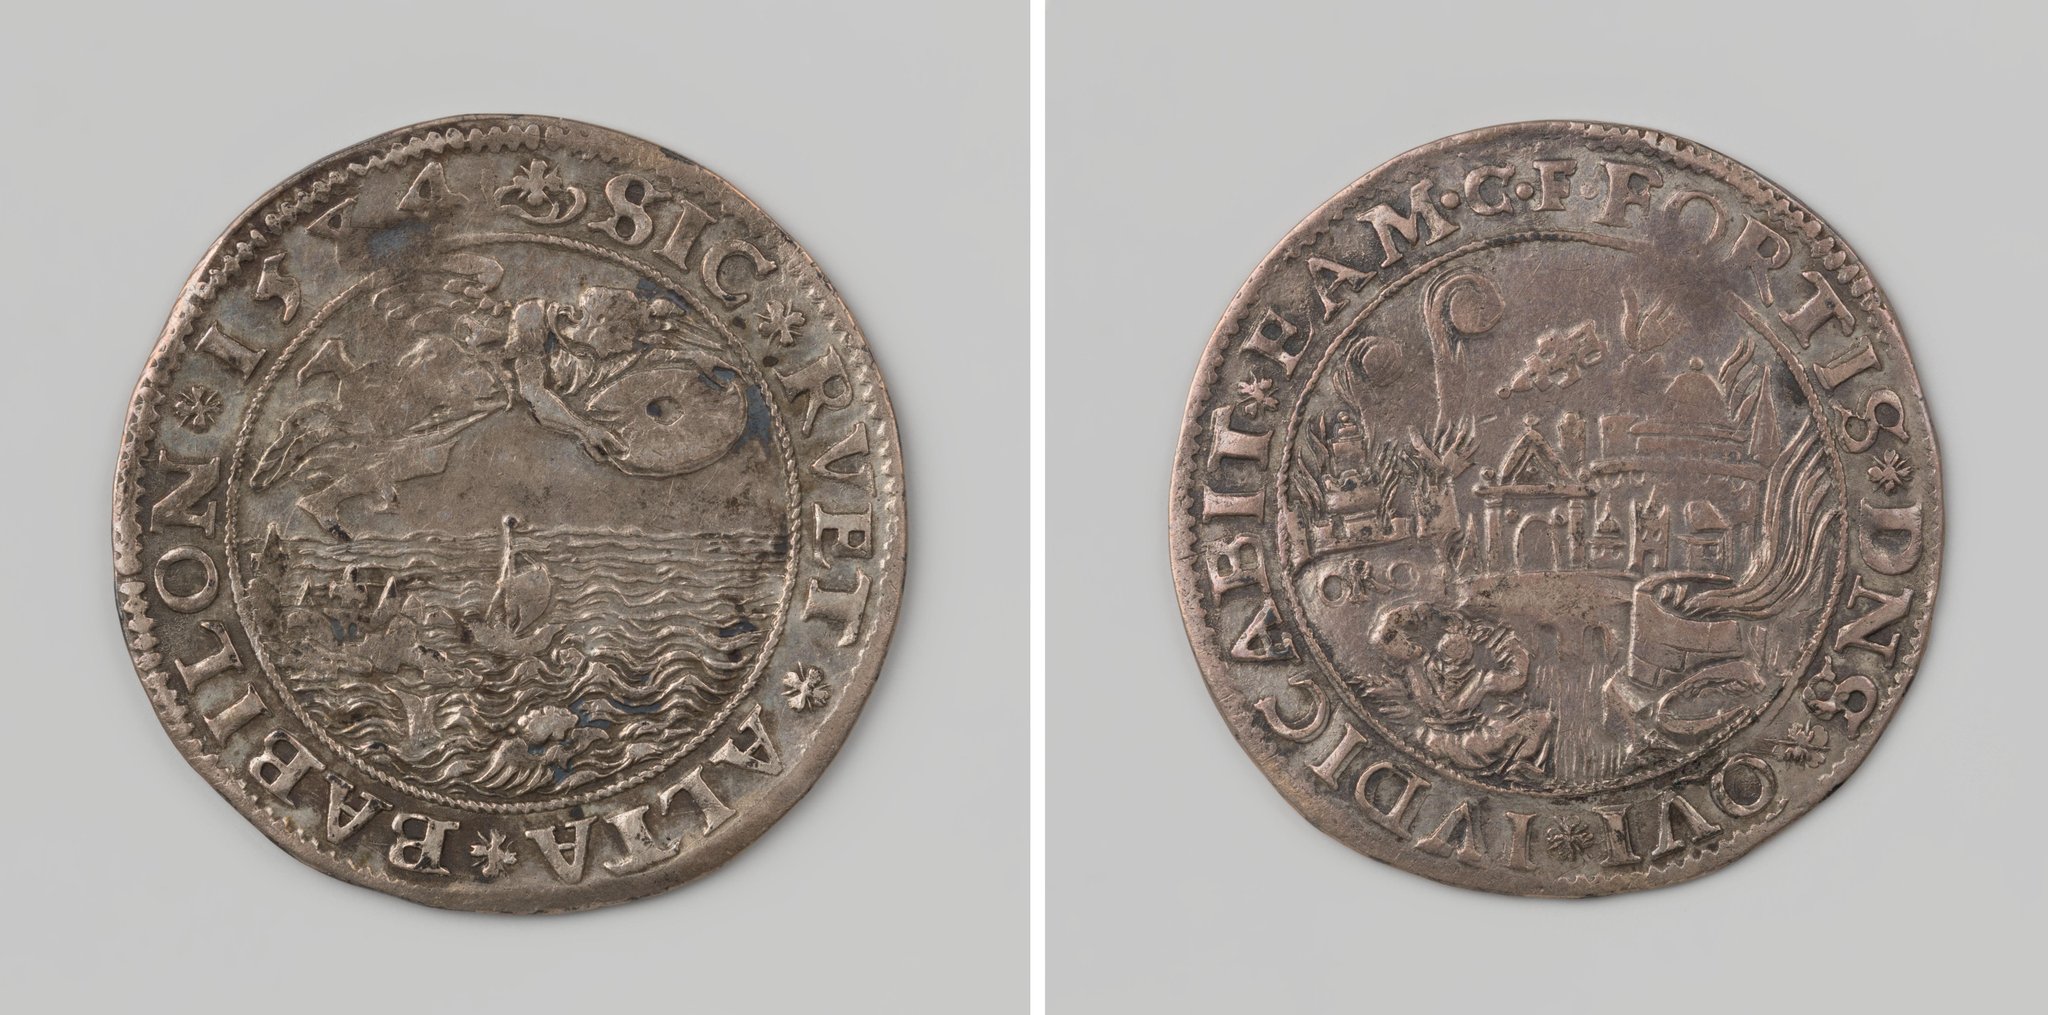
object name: jeton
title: Allegorie op de verwachte ondergang van het rooms-katholieke geloof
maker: Anonymous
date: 1584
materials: silver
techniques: striking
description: Zilveren penning. Voorzijde: engel werpt molensteen in zee. Keerzijde: brandende stad Rome; op voorgrond treurende vrouw en opschrift ORO binnen omschrift